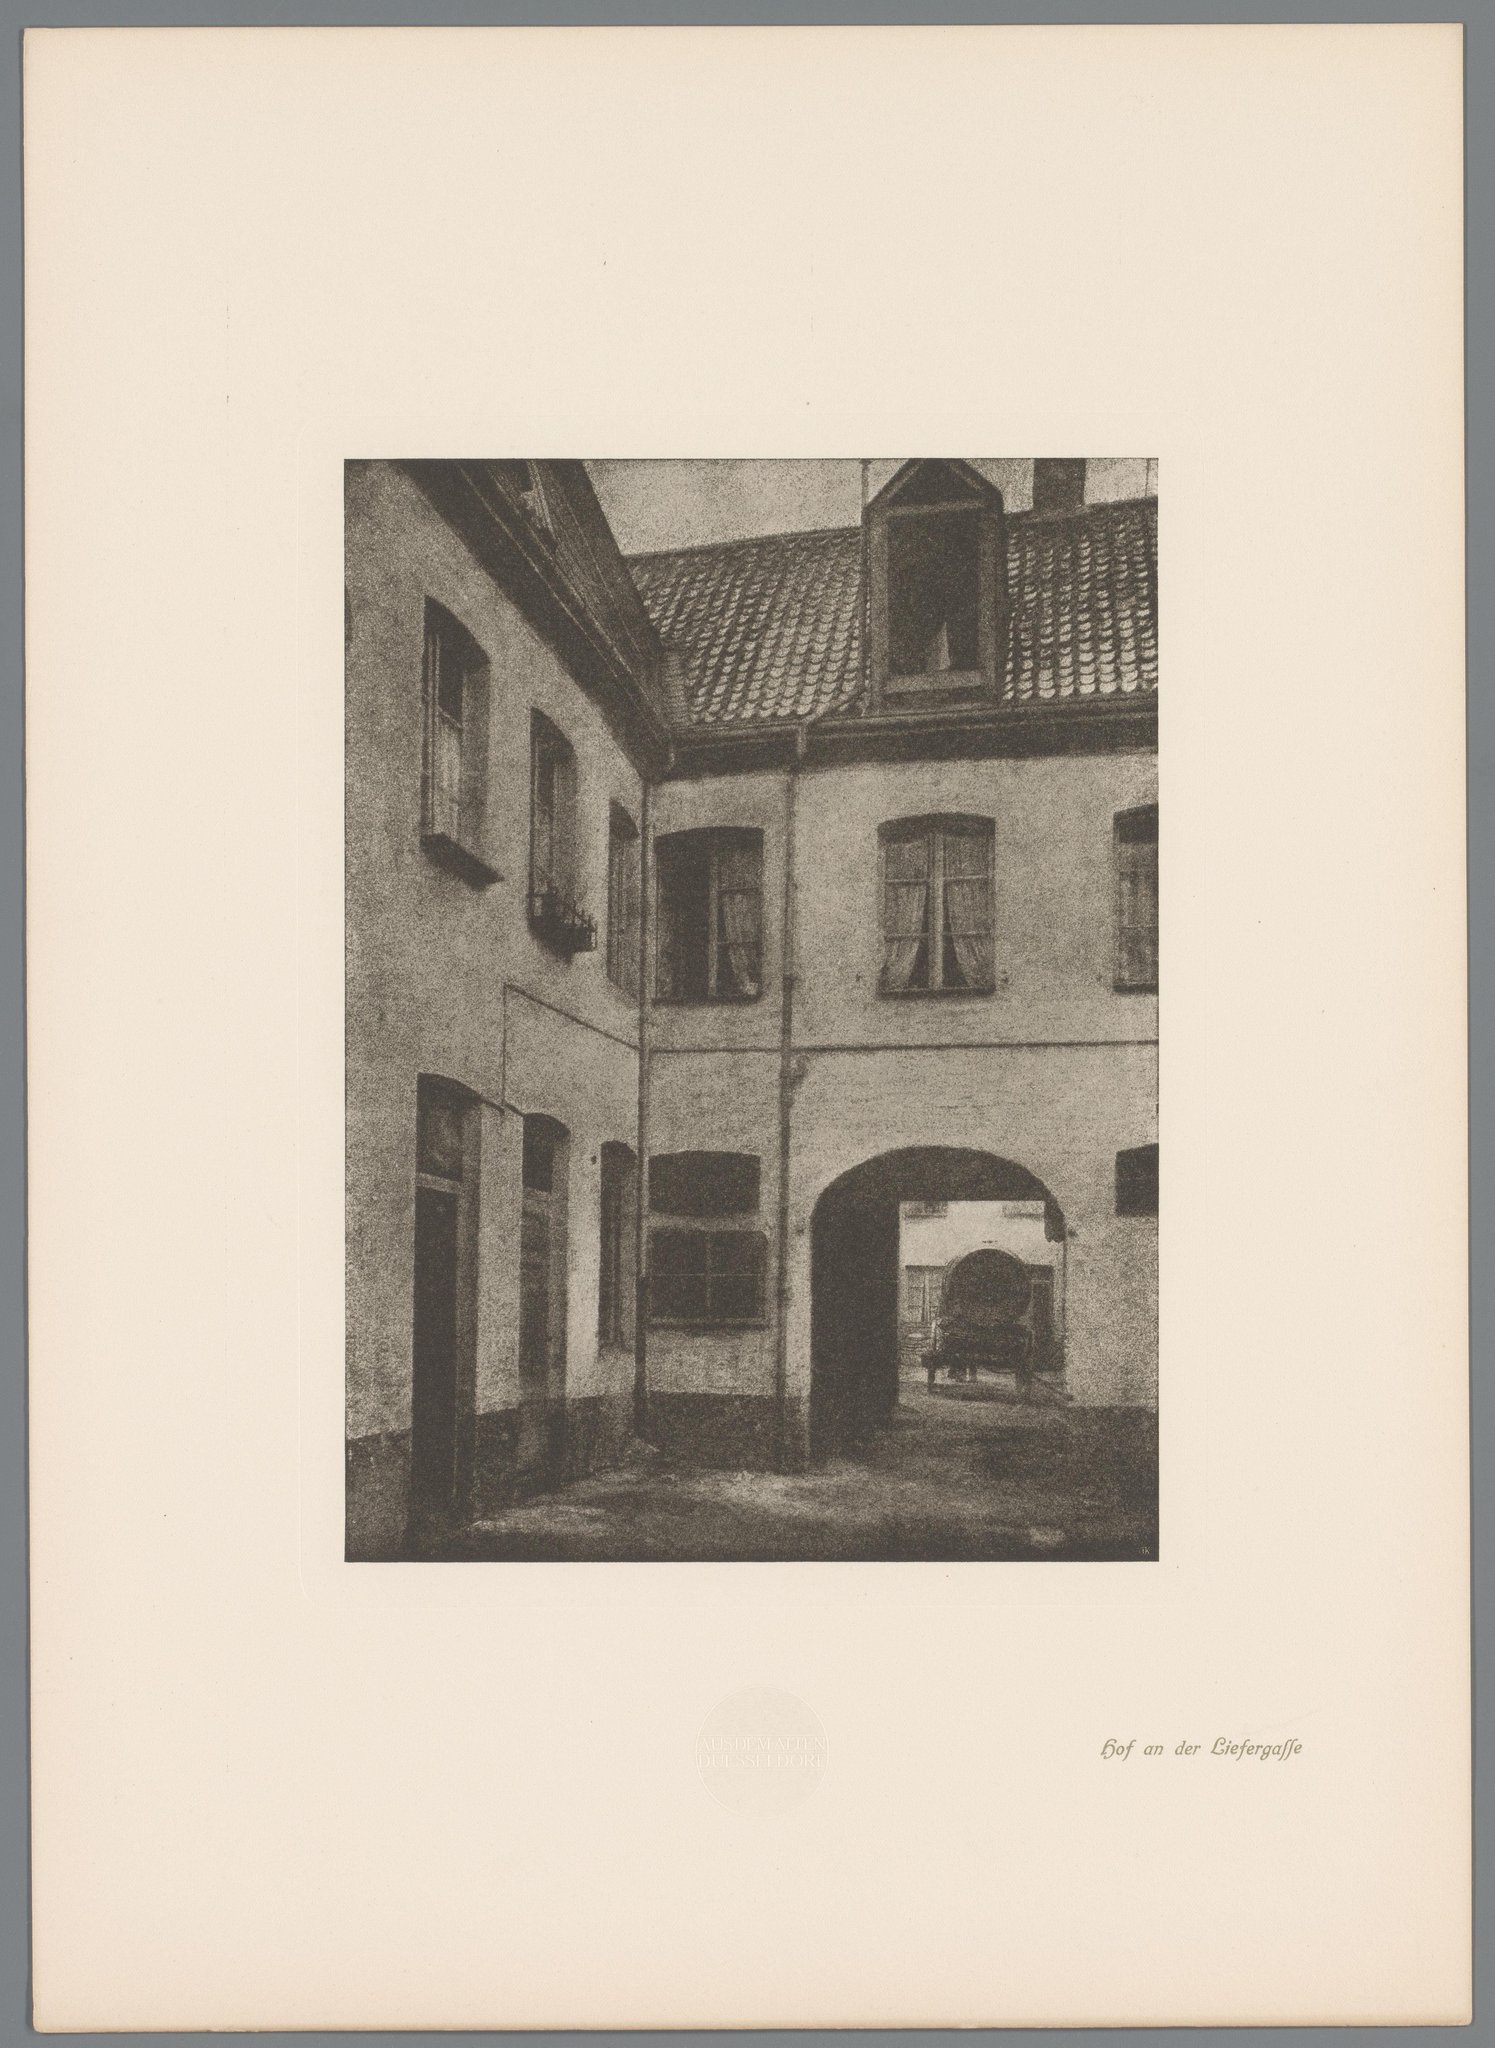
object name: reproduction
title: Reproductie van een gomdruk van een binnenplaats in de Liefergasse in Düsseldorf door Erwin Quedenfeldt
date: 1902-1907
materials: paper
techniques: autotype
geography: offenbach am main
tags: courtyard